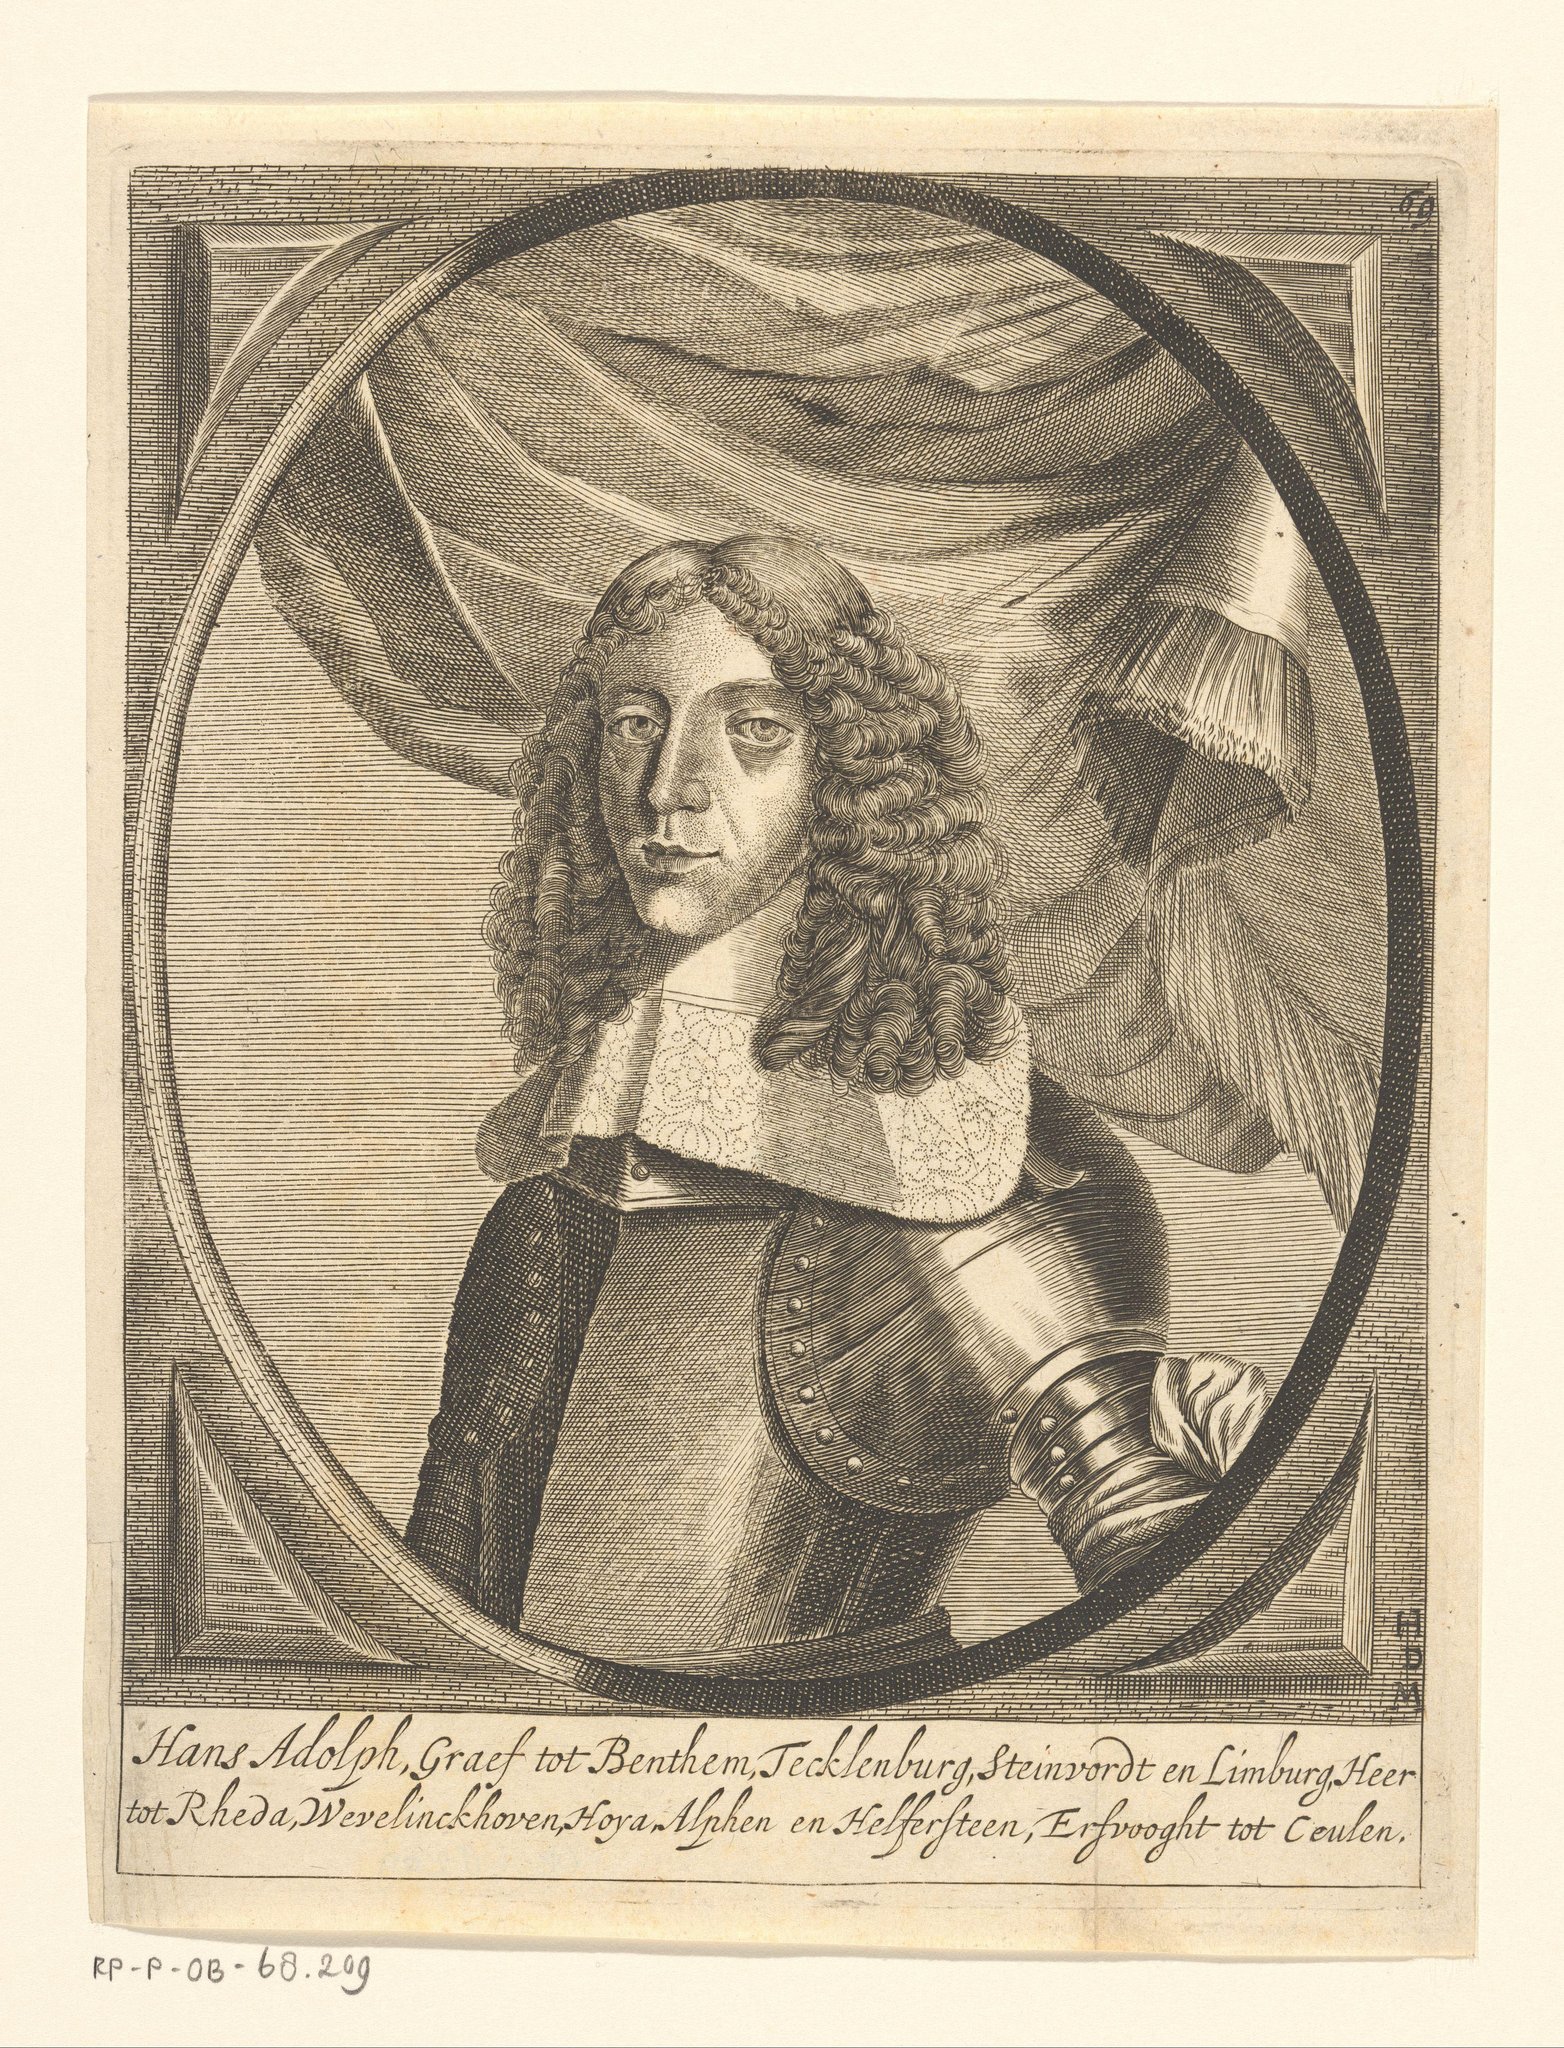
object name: print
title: Portret van graaf Hans Adolf van Bentheim-Tecklenburg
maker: monogrammist hdm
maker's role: print maker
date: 1650-1700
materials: paper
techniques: engraving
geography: low countries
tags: earl, historical persons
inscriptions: collector's mark: Lugt 964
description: Portret van graaf Hans Adolf van Bentheim-Tecklenburg in wapenrusting. Achter hem een draperie en rondom een omlijsting. Onder in de marge een tweeregelig onderschrift met de naam en titel van de geportretteerde.